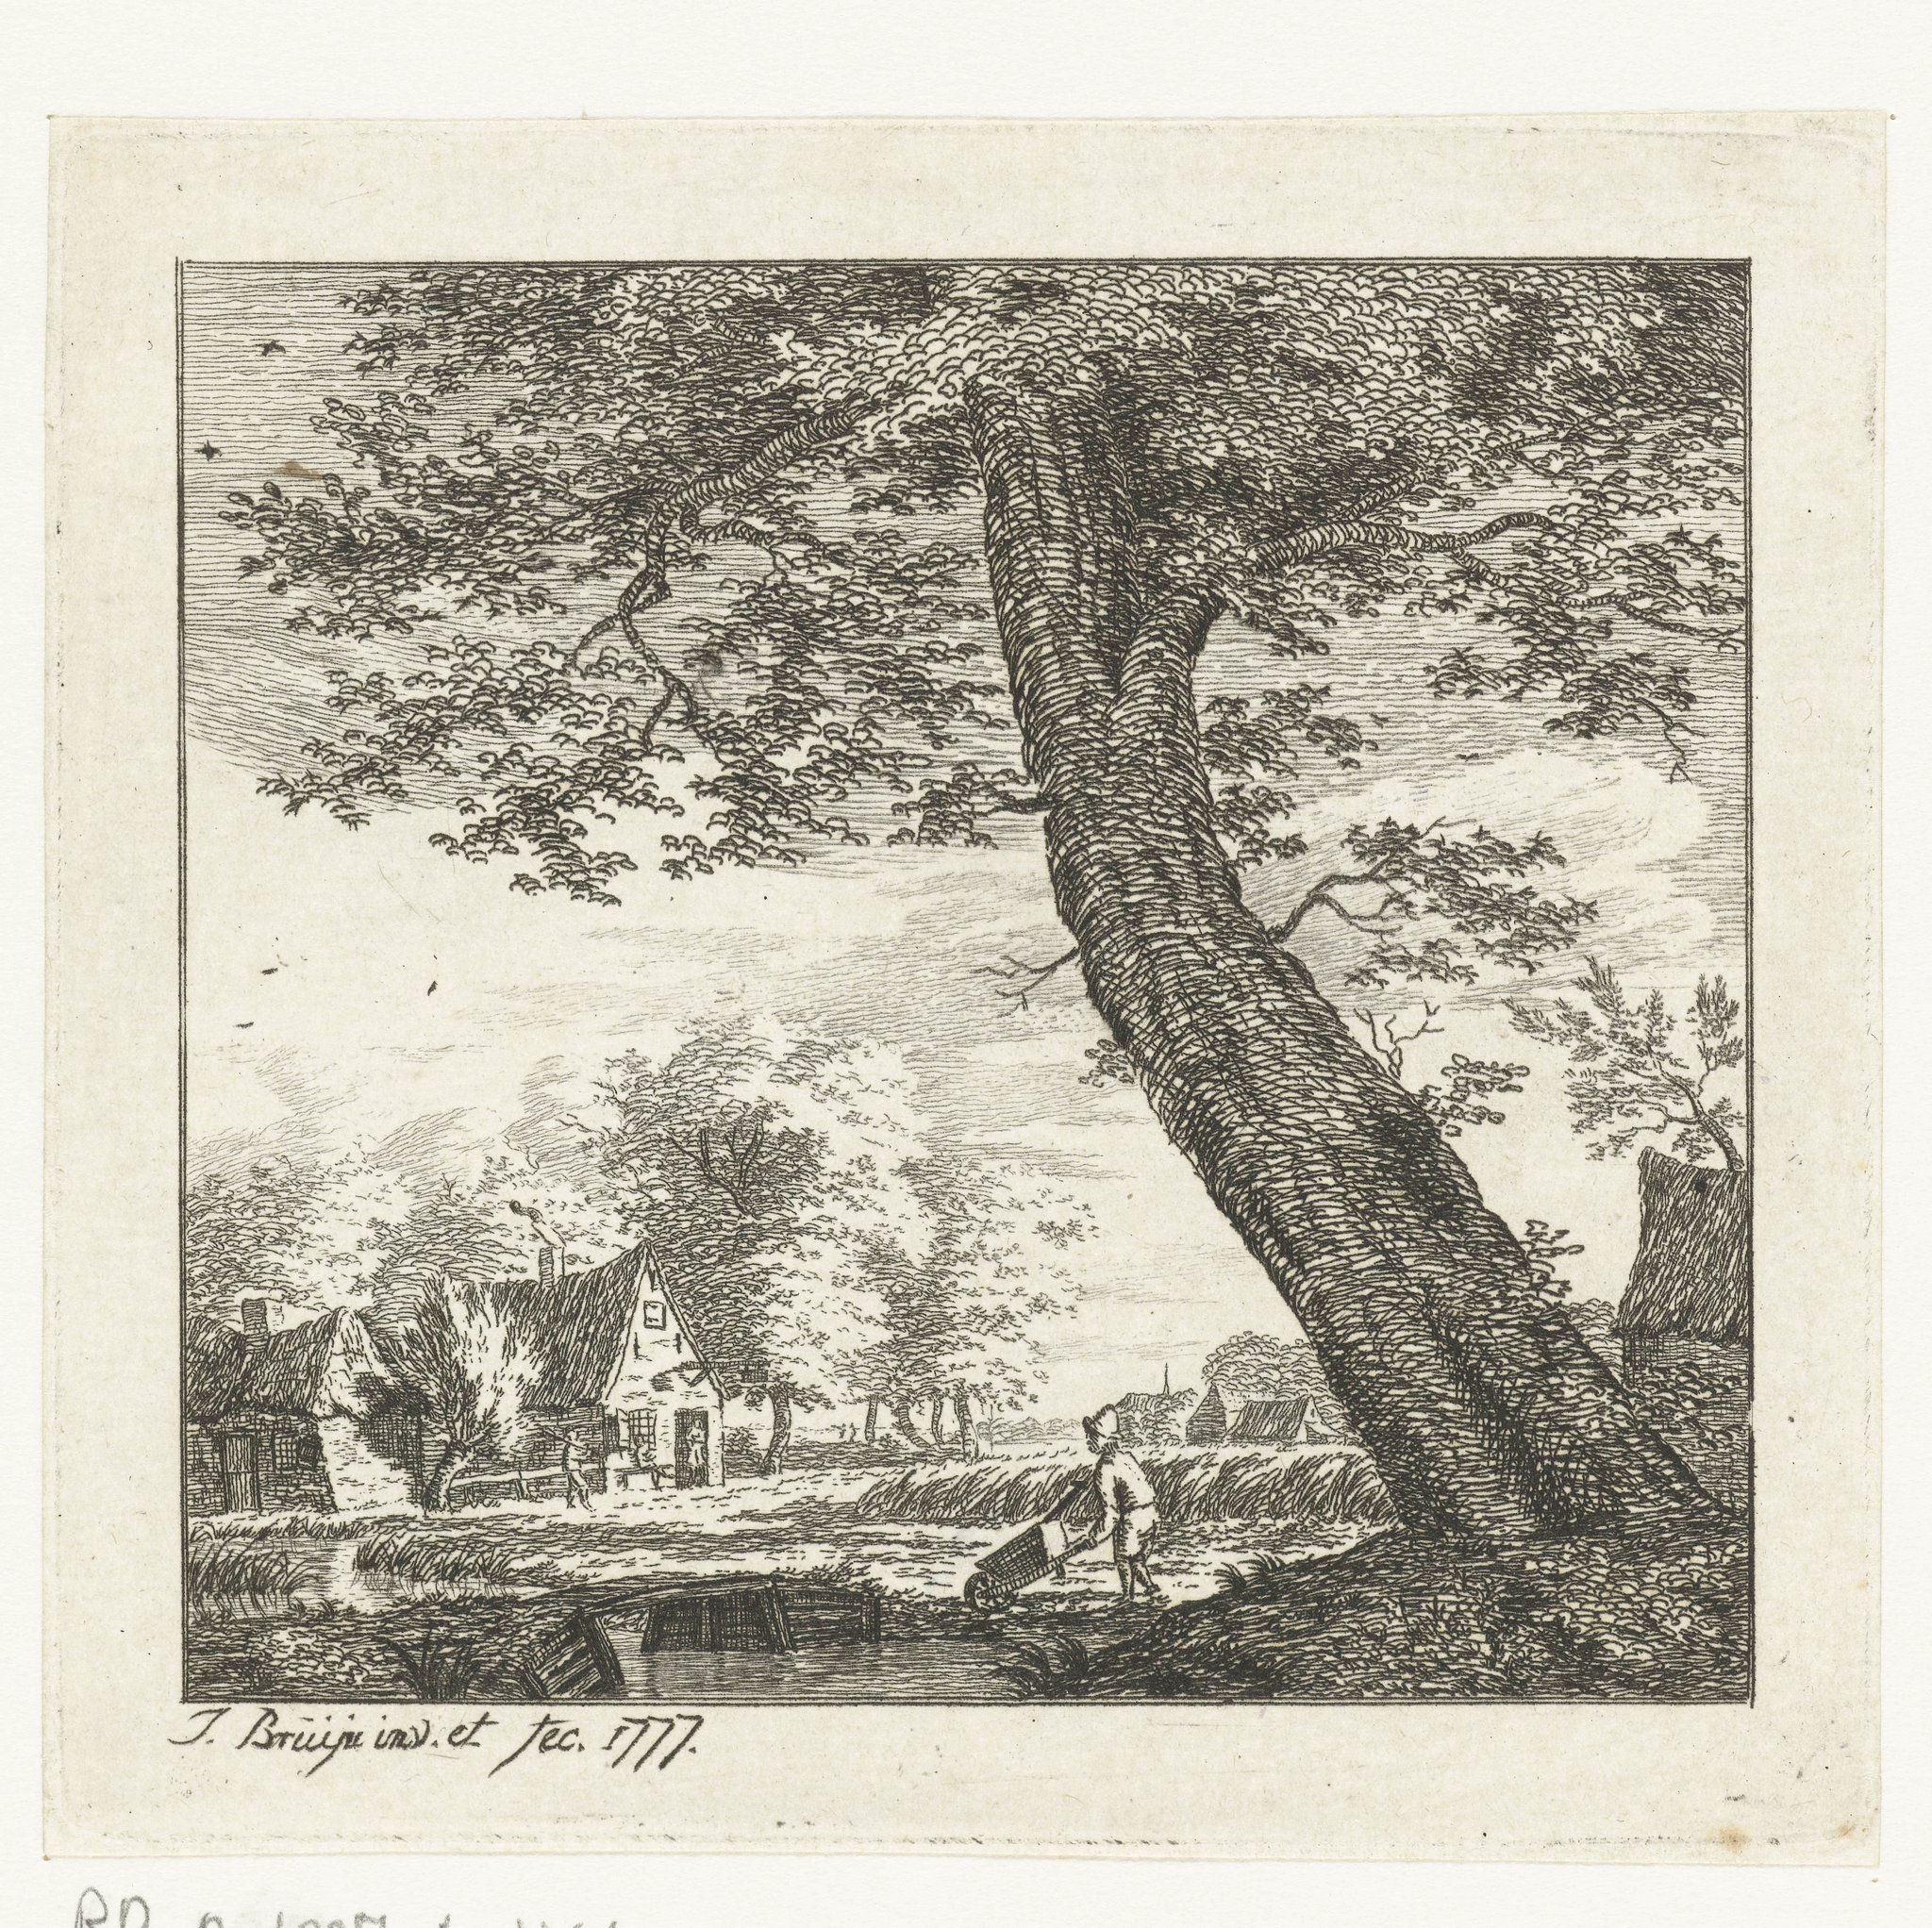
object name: print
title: Dorpsgezicht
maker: johanna de bruyn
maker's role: draughtsman, print maker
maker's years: 1722-1782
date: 1777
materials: paper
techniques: etching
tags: wheelbarrow, village lane, alley, bridge in village across river, canal, etc.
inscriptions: collector's mark: Lugt 2228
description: Gezicht op een dorp. Een man met een kruiwagen wandelt op de weg langs de rivier. Op de achtergrond een andere wandelaar bij een boerderij.